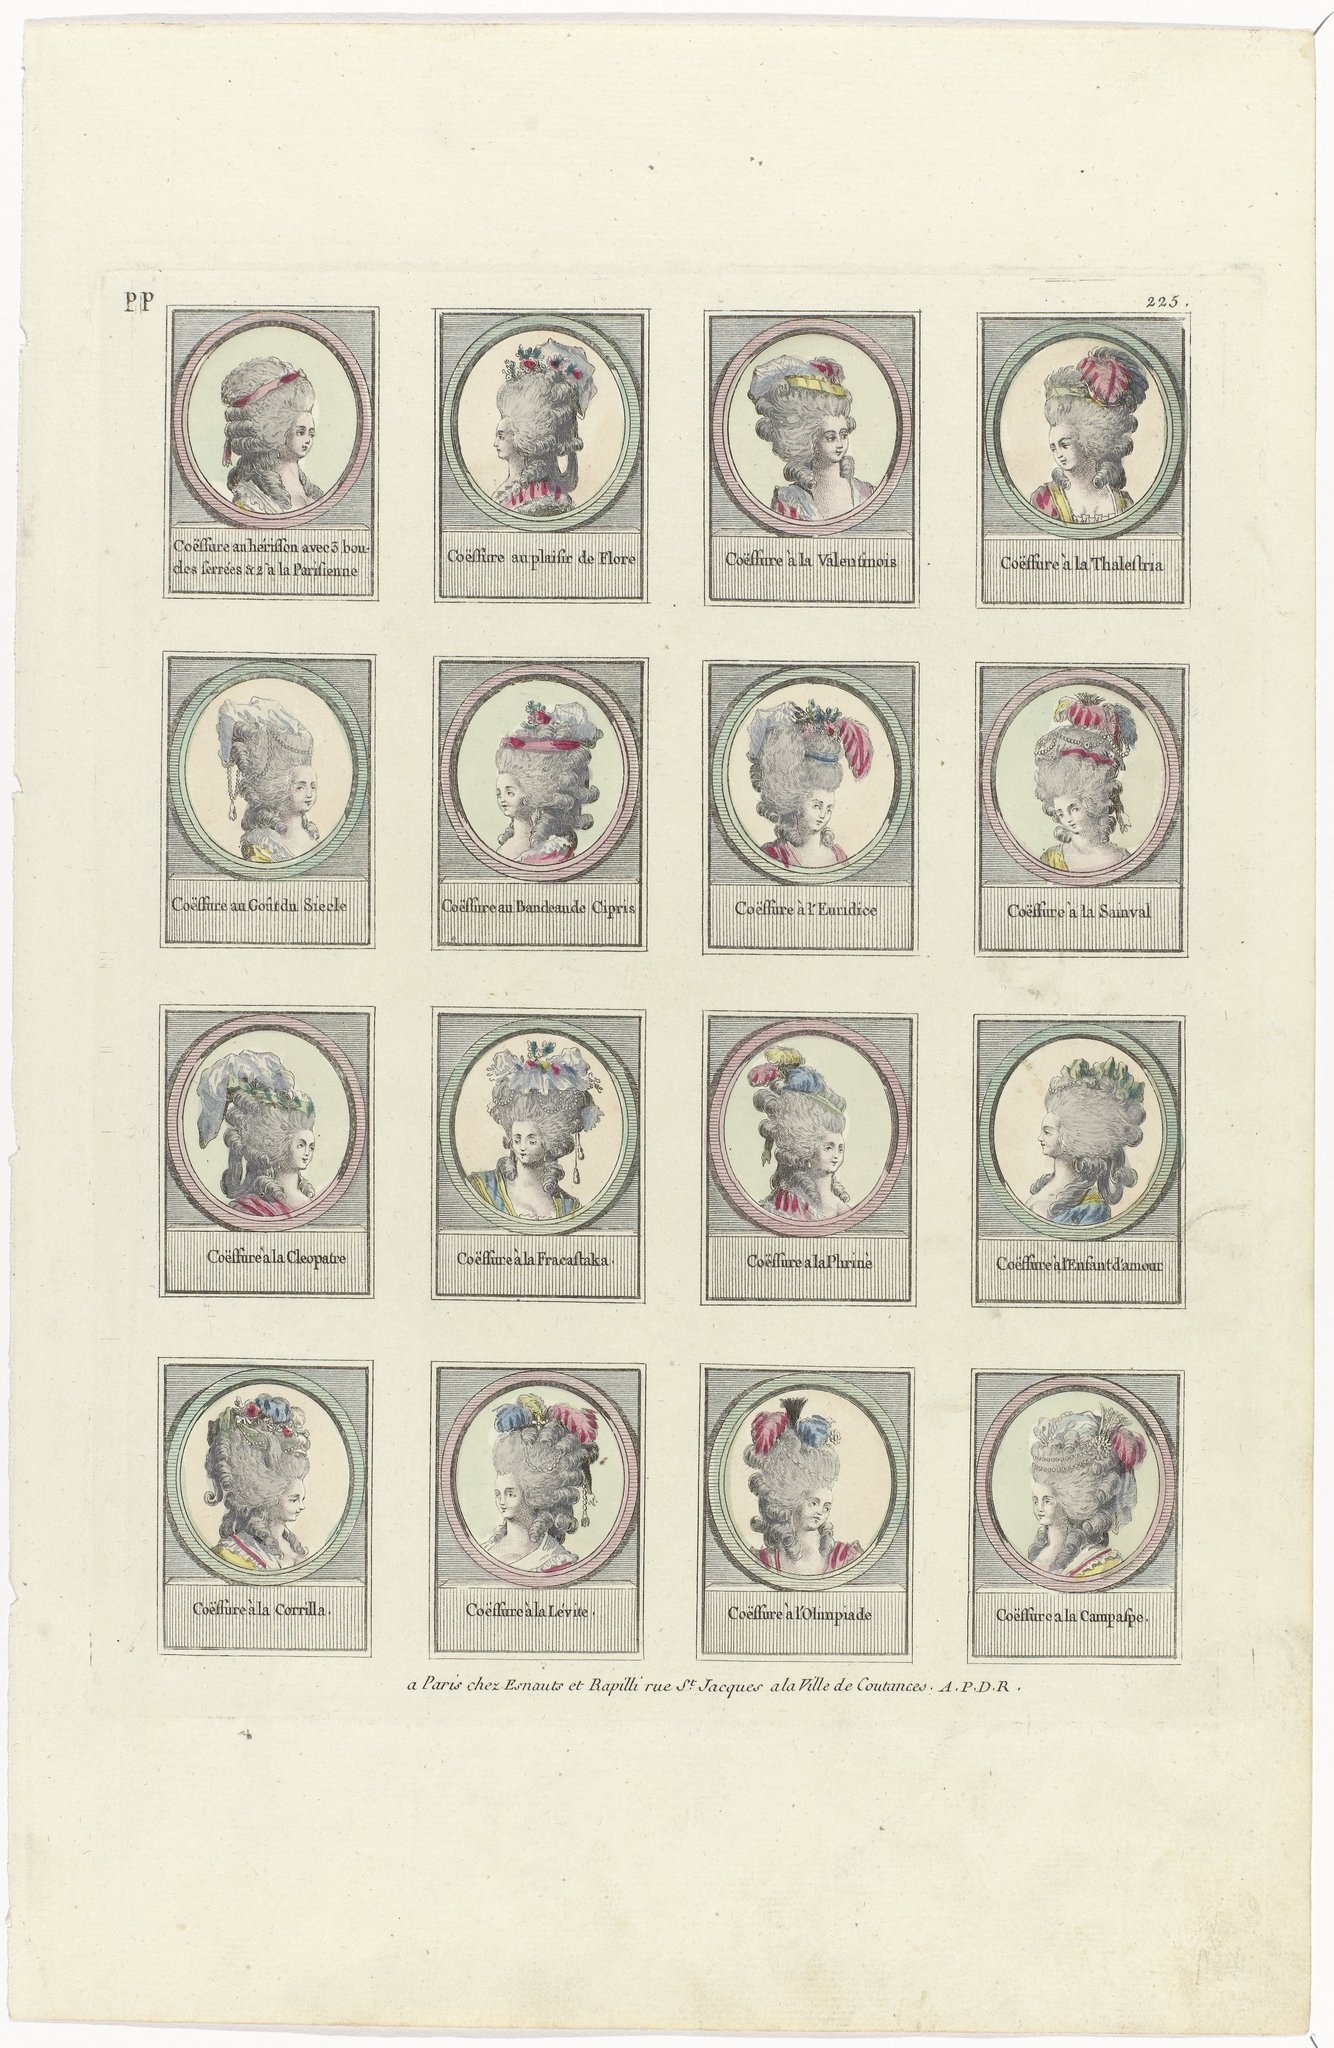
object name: fashion print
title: Gallerie des Modes et Costumes Français, 1781, pp 225 : Coëffure au hérisson (...)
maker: Anonymous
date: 1781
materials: paper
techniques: engraving, hand coloring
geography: paris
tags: clothing for the upper part of the body (+ women's clothes), styles of hairdress - aa - ~ women, fashion plates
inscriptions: inscription: ‘Coëffure à la Cleopatre / Coëffure à la Fracastaka / Coëffure a la Phrinè / Coëffure à l'Enfant d'amour’, address: ‘A Paris chez Esnauts et Rapilli rue St. Jacques a la Ville de Coutances. A.P.D.R.’, inscription: ‘Coëffure à la Corrilla / Coëffure à la Lévite / Coëffure à l'Olimpiade / Coëffure a la Campaspe’, inscription: ‘Coëffure au Goût Siecle / Coëffure au Bandeau de Cipris / Coëffure à l'Euridice / Coëffure à la Sainval’, inscription: ‘Coëffure au hérisson avec 3 boucles serrées (...onleesbaar...) 2 à la Parisienne / Coëffure au plaisir de Flore / Coëffure à la Valentinois / Coëffure à la Thalestria’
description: Zestien verschillende dameskapsels, in vier rijen van vier, in ovalen. Van linksboven naar rechtsonder: Coëffure au hérisson avec 3 boucles serrées et 2 à la Parisienne. Coëffure au plaisir de Flore. Coëffure à la Valentinois. Coëffure à la Thalestria Coëffure au Goût du Siecle. Coëffure au Bandeau de Cipris. Coëffure à l'Euridice. Coëffure à la Sainval. Coëffure à la Cleopatre. Coëffure à la Fracastaka. Coëffure a la Phrinè. Coëffure à l'Enfant d'amour. Coëffure à la Corrilla. Coëffure à la Lévite. Coëffure à l'Olimpiade. Coëffure a la Campaspe.' Prent uit de serie pp. 39e Cahier des Costumes Français, 10e Suite des Coeffures à la mode en 1781, Gallerie des Modes et Costumes Français.